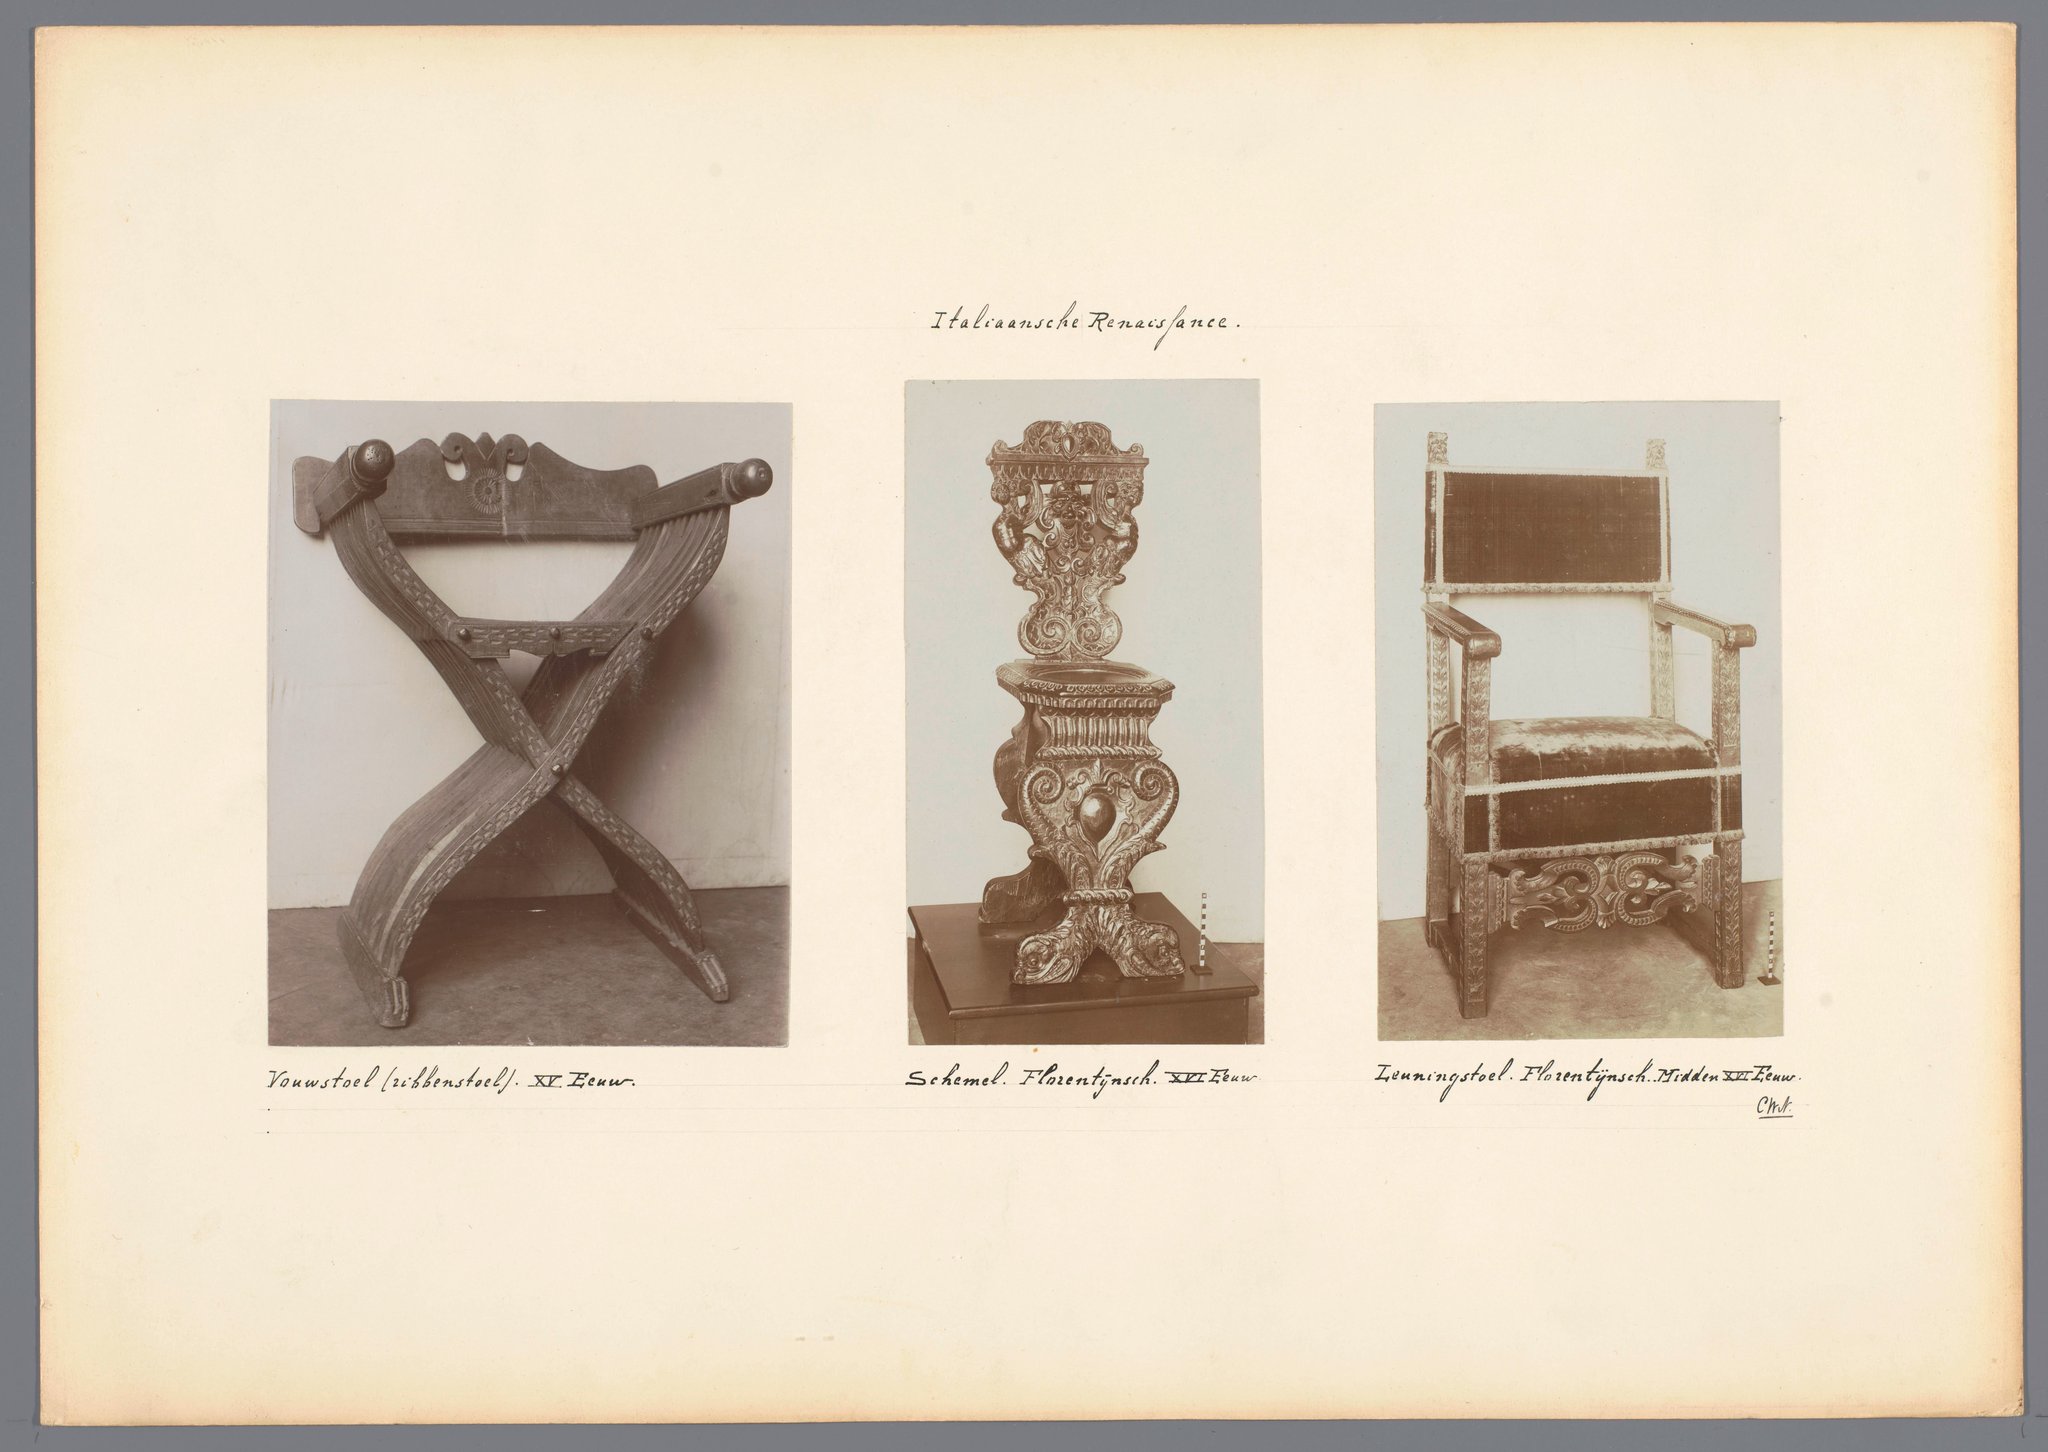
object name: photograph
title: Vouwstoel (ribbenstoel). XV Eeuw.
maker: Anonymous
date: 1875-1900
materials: cardboard, photographic support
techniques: collodion silver print, gelatin silver print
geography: europe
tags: armchair, seat, rosette ~ ornament, monsters of the sea, ornament derived from plant forms, europe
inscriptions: inscription: ‘CWN.’, inscription: ‘Italiaansche Renaissance.’, collector's mark: ‘KUNSTNIJVERHEIDSCHOOL QUELLINUS AMSTERDAM FRANS HALSSTRAAT 14.’, collector's mark: ‘INSTITUUT VOOR KUNST-NIJVERHEIDSONDERWIJS GABRIËL METSUSTRAAT No. 16 AMSTERDAM’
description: Links een vouwstoel van notenhout met op de rugleuning een rozet, midden een sgabello gedecoreerd met zeewezens, rechts een stoel met armleggers gedecoreerd met plantmotieven en twee koppen als bekroning van de achterstijlen.